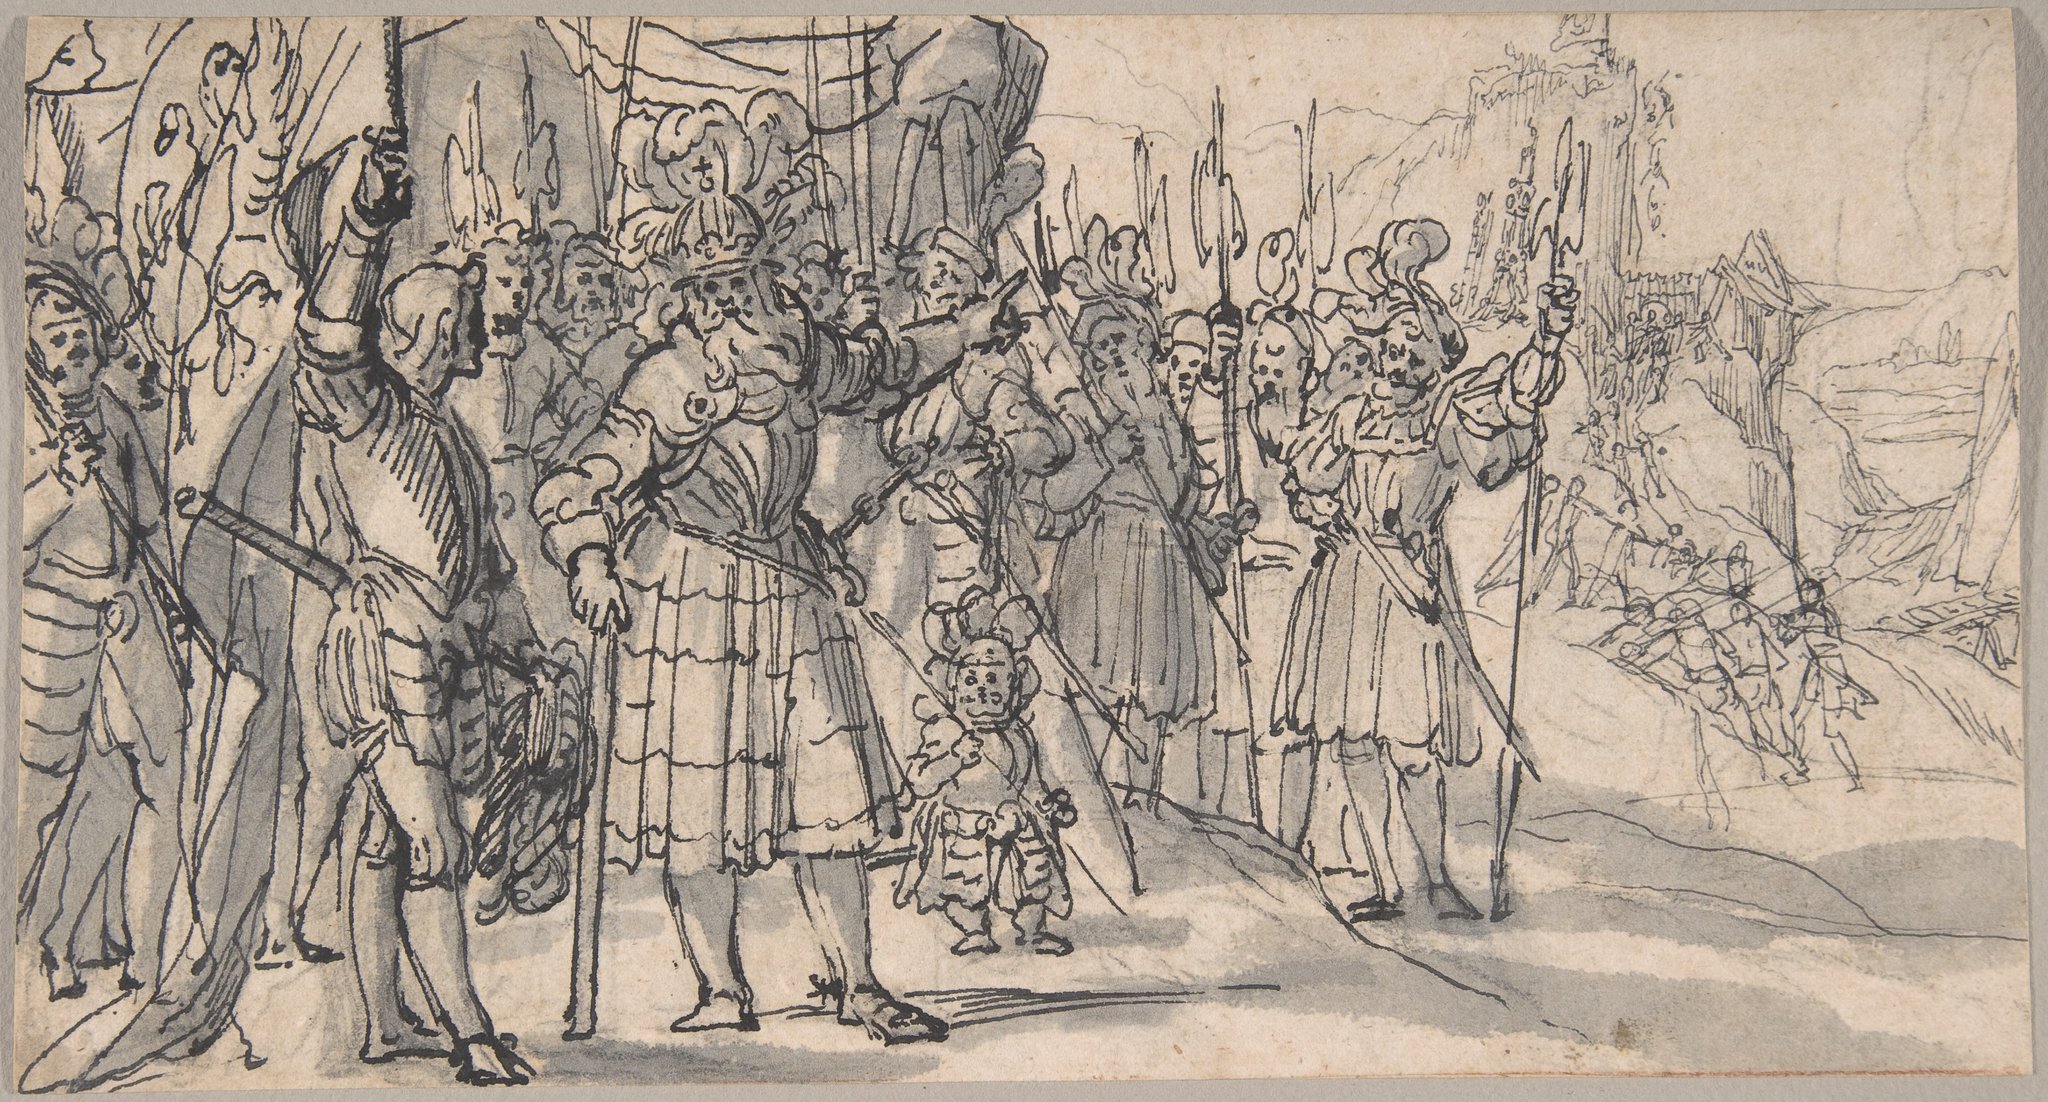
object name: drawing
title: Otto von Wittelsbach Liberates the Army from a Mountain Pass near Verona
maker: peter candid (pieter de witte, pietro candido)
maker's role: artist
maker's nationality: netherlandish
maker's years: 1548-1628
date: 1604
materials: chalk, ink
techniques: pen, wash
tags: army,weapons,men